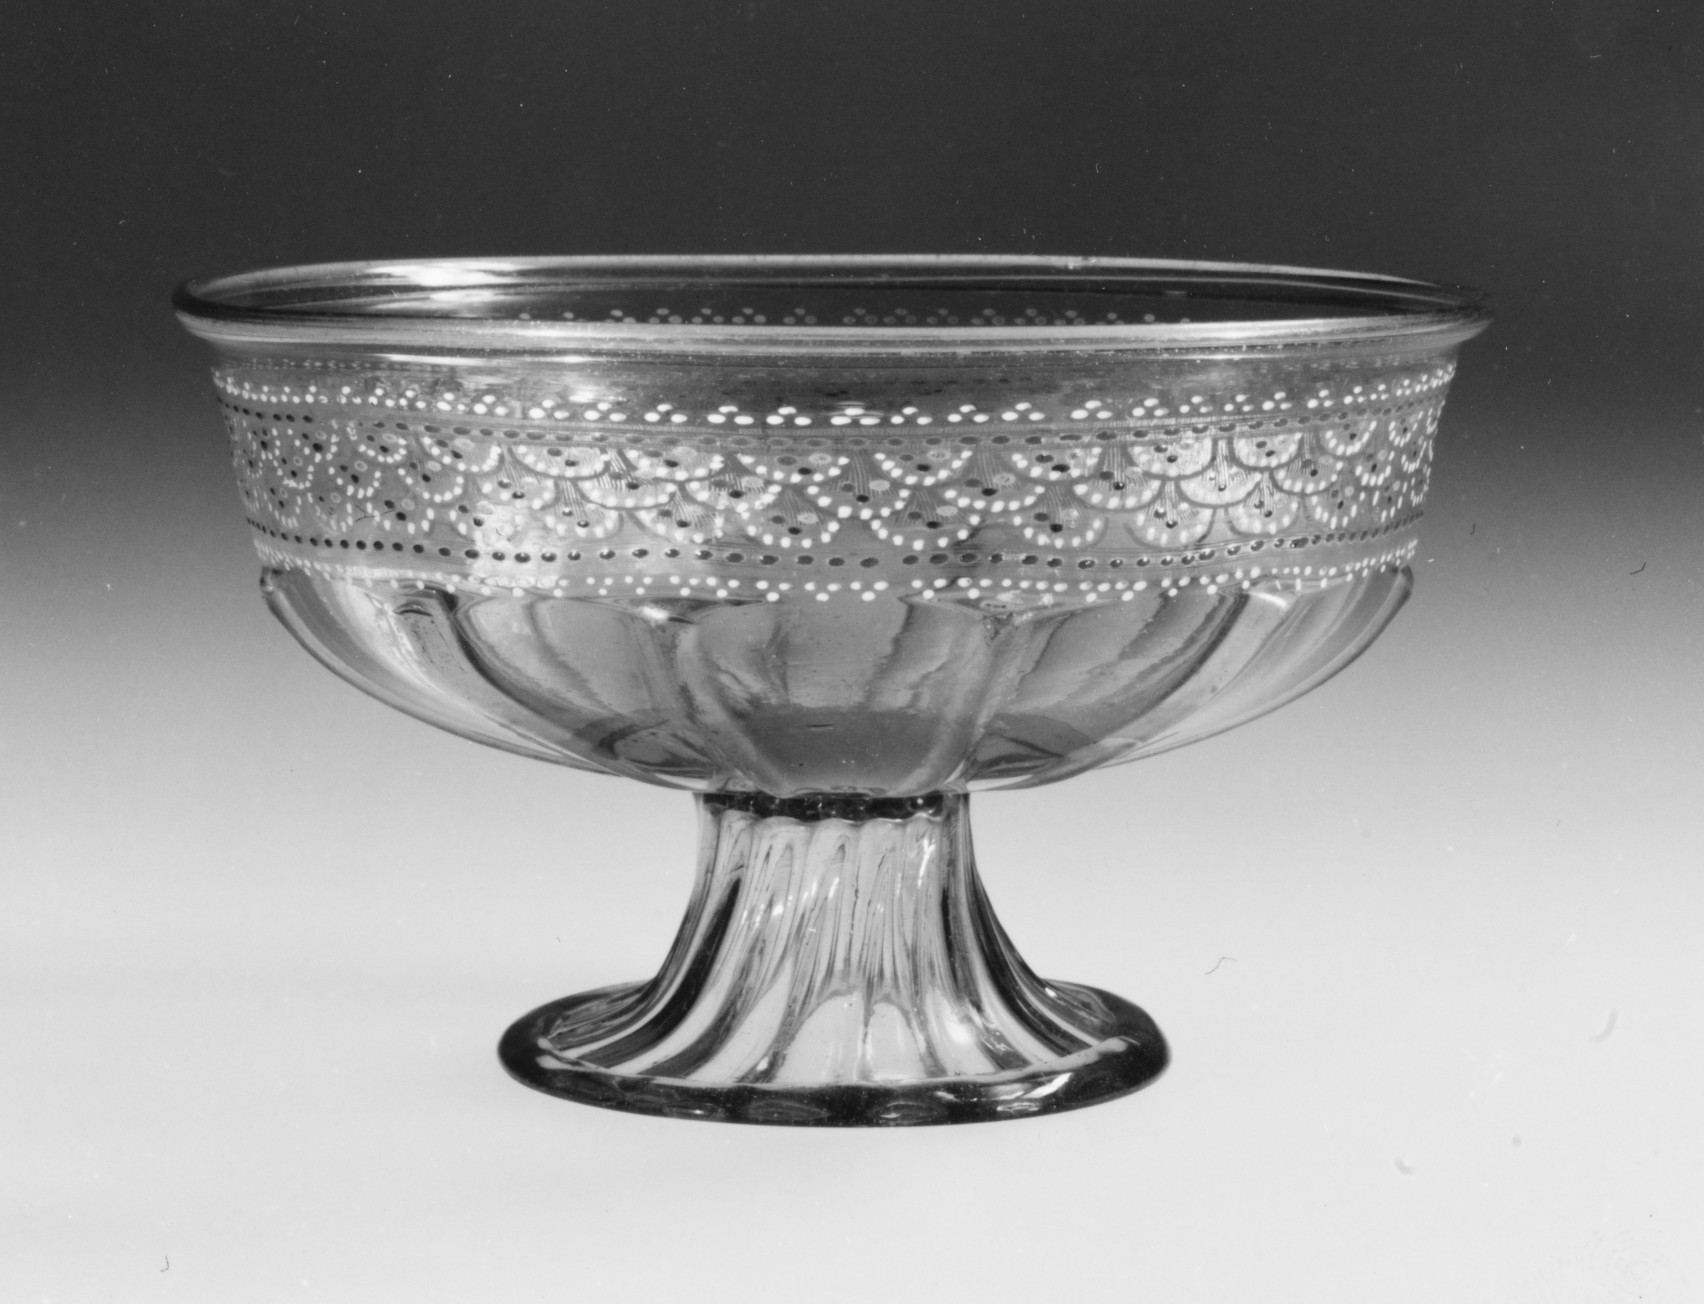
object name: bowl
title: Footed bowl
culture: italian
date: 1500-1525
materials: gilt, glass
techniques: glassblowing, enamel, molding